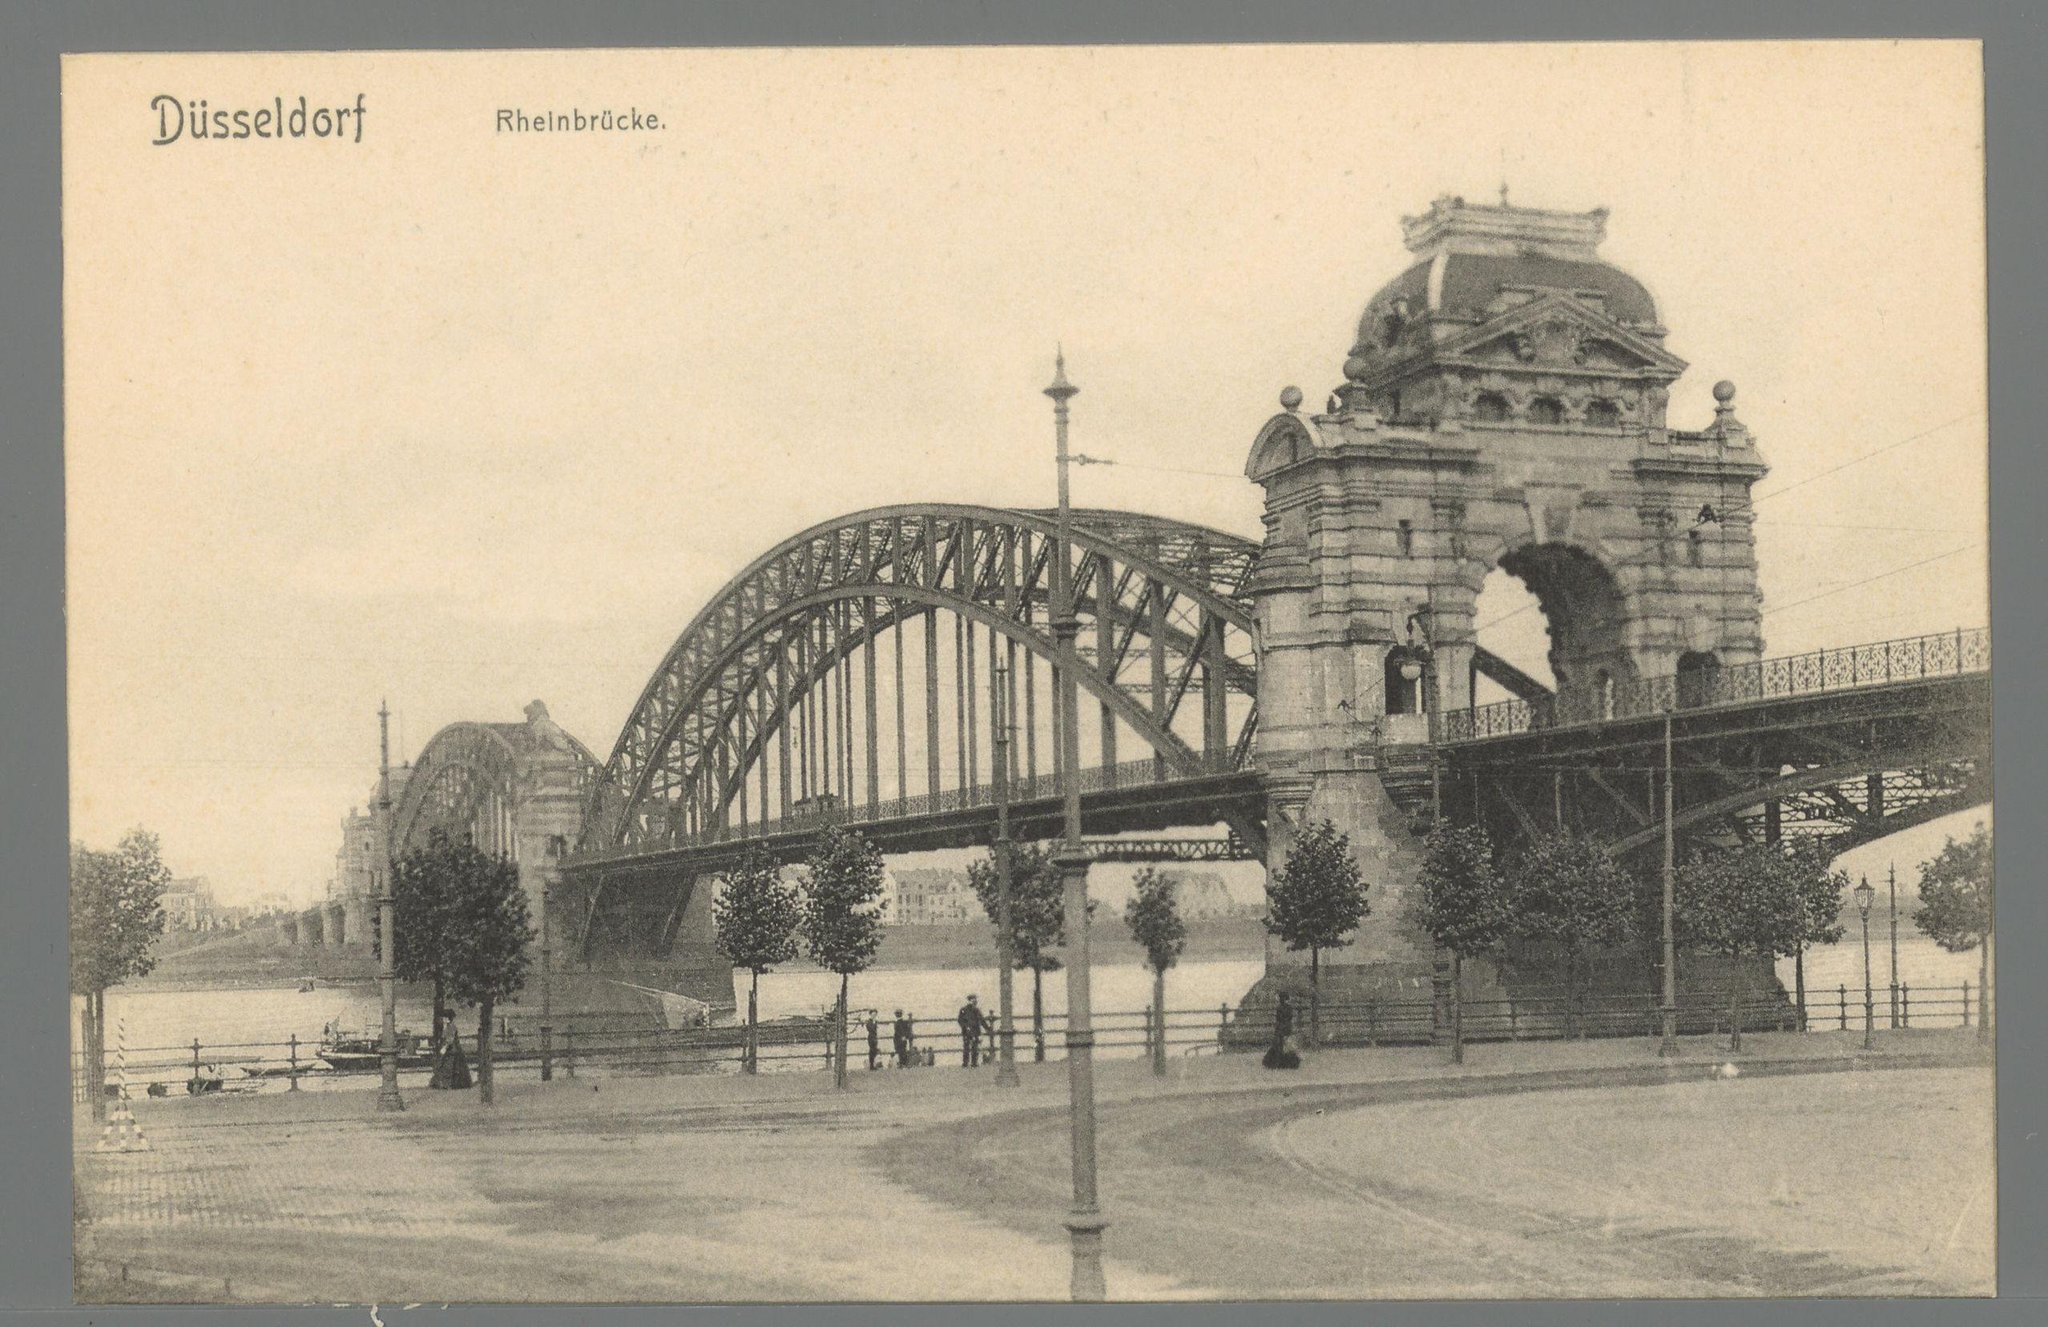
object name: photomechanical print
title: Düsseldorf. Rheinbrücke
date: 1905-1930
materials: cardboard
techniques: photograph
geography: dusseldorf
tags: canals, waters (in city), bridge in city across river, canal, etc.